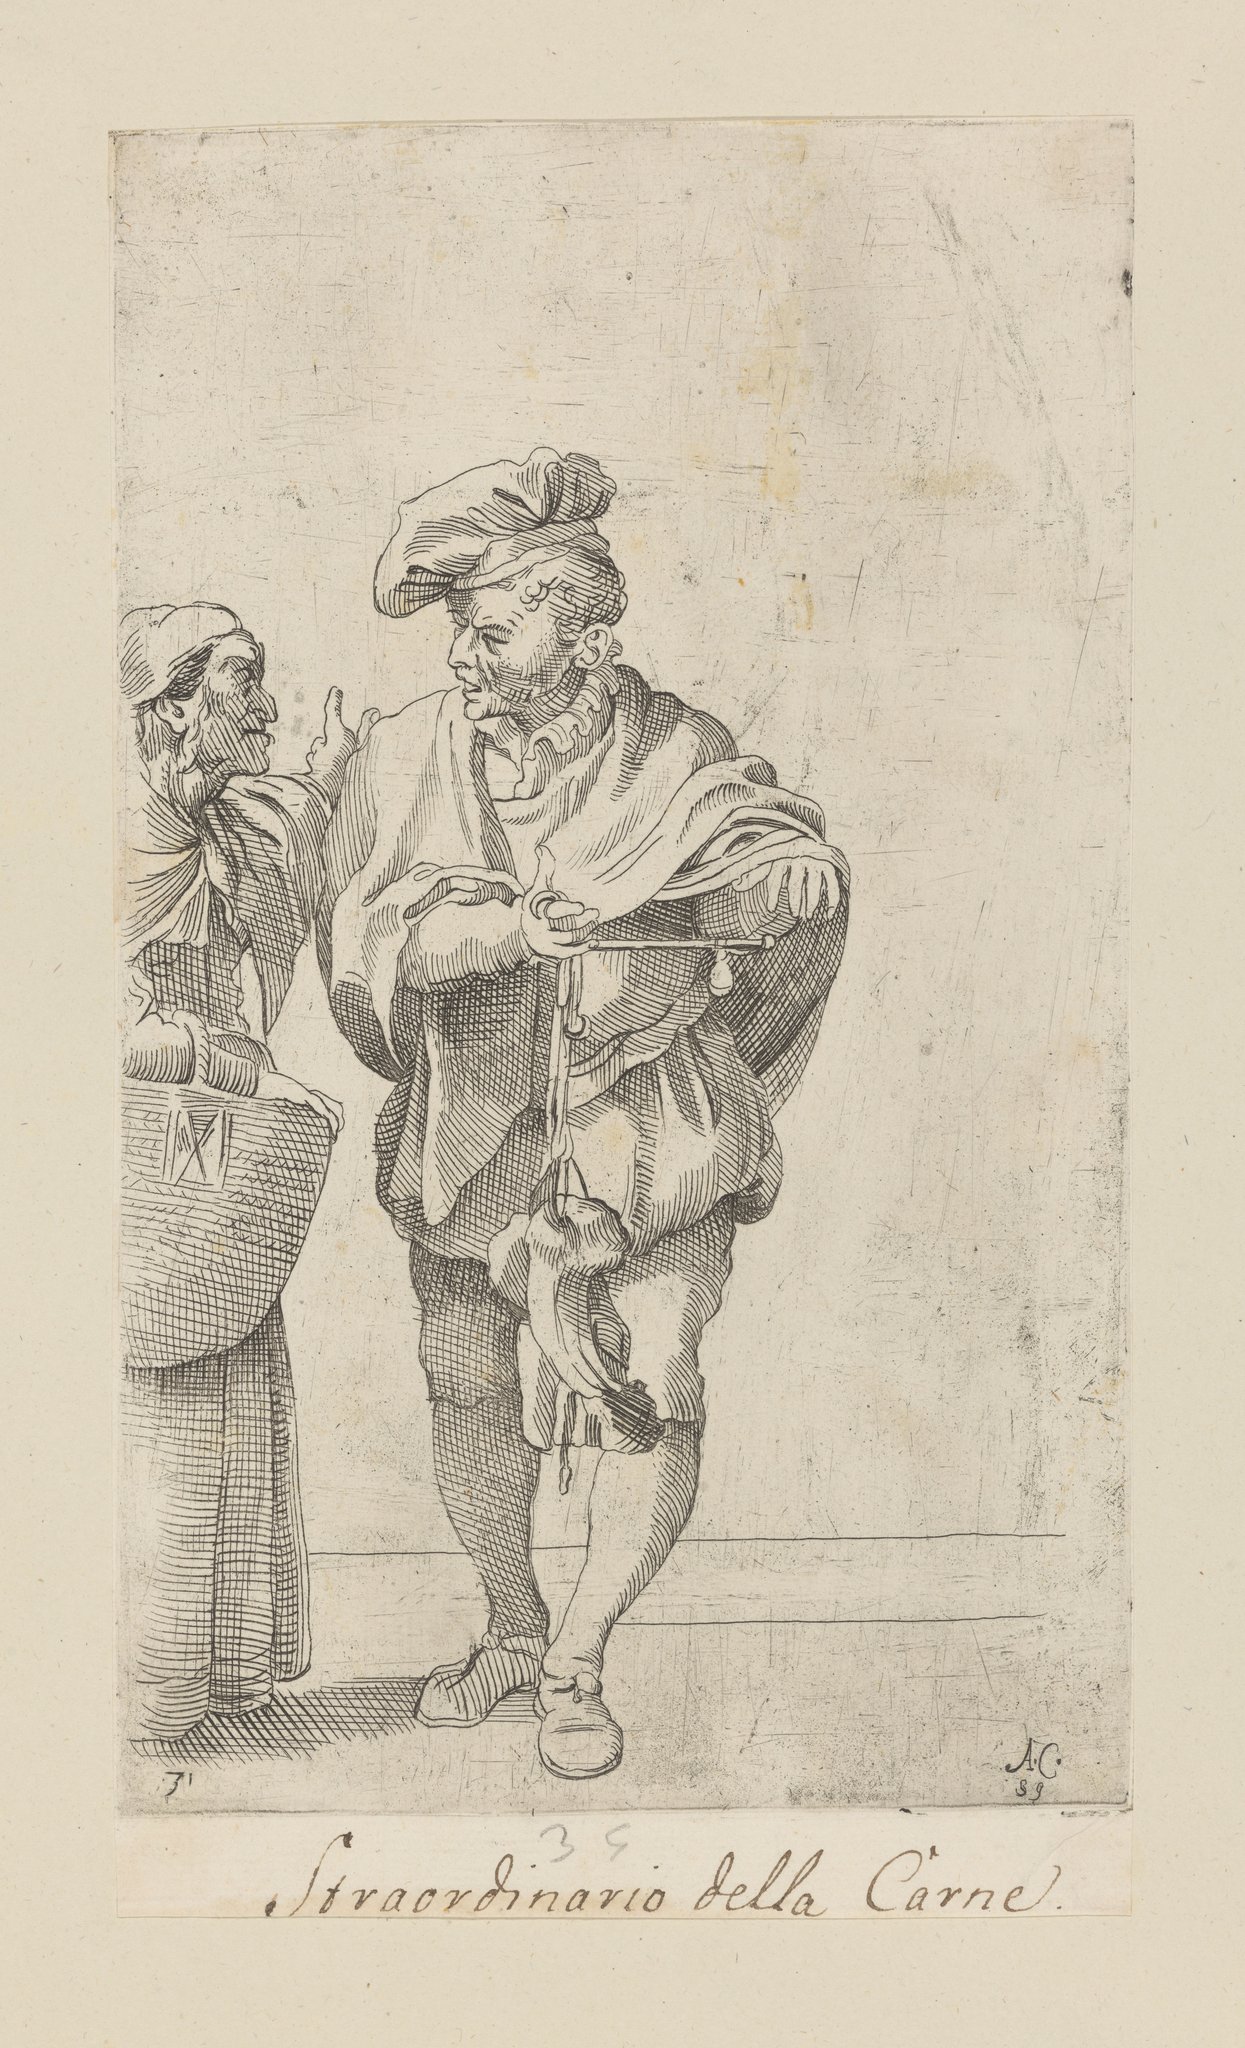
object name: print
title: Plate 31: Meat vendor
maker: simon guillain ii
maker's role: artist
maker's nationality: french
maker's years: 1618-1718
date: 1646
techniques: etching